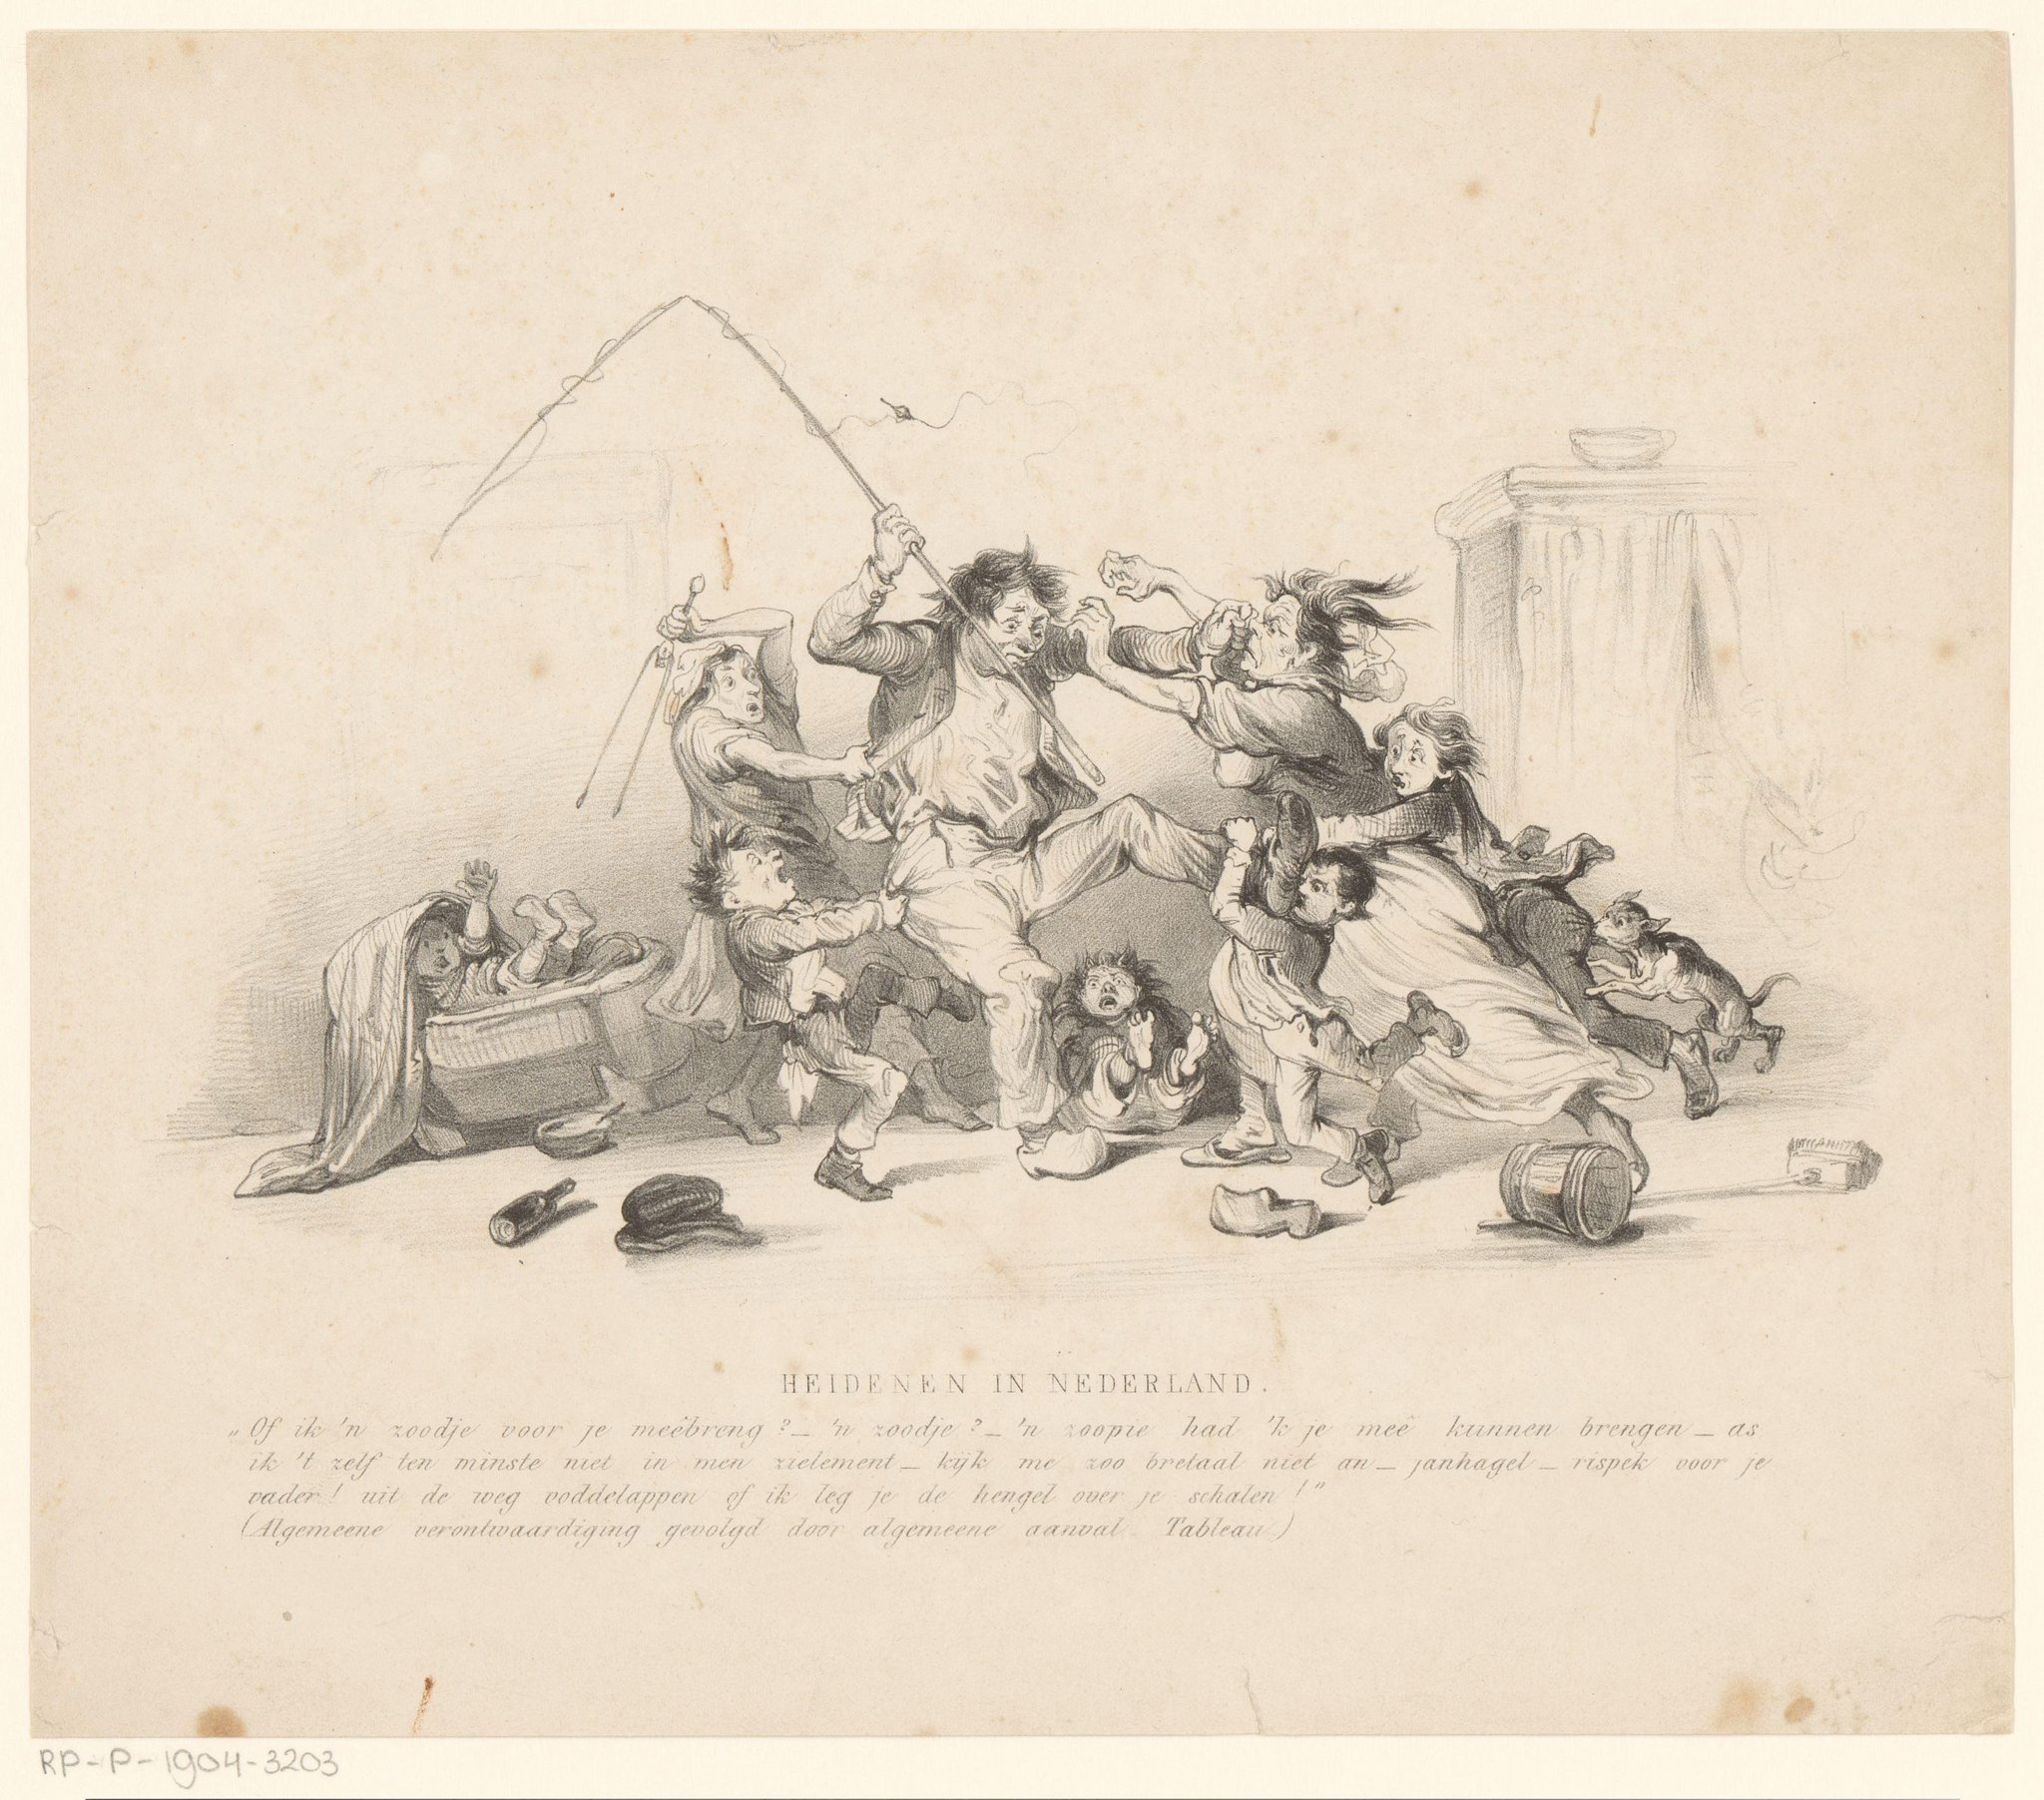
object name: cartoon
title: Vrouwen en kinderen vallen man aan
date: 1832-1897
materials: paper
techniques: lithograph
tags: fighting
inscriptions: collector's mark: Lugt 2228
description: Een man met hengel wordt aangevallen door twee vrouwen en kinderen die hij van zich af probeert te schoppen en slaan.